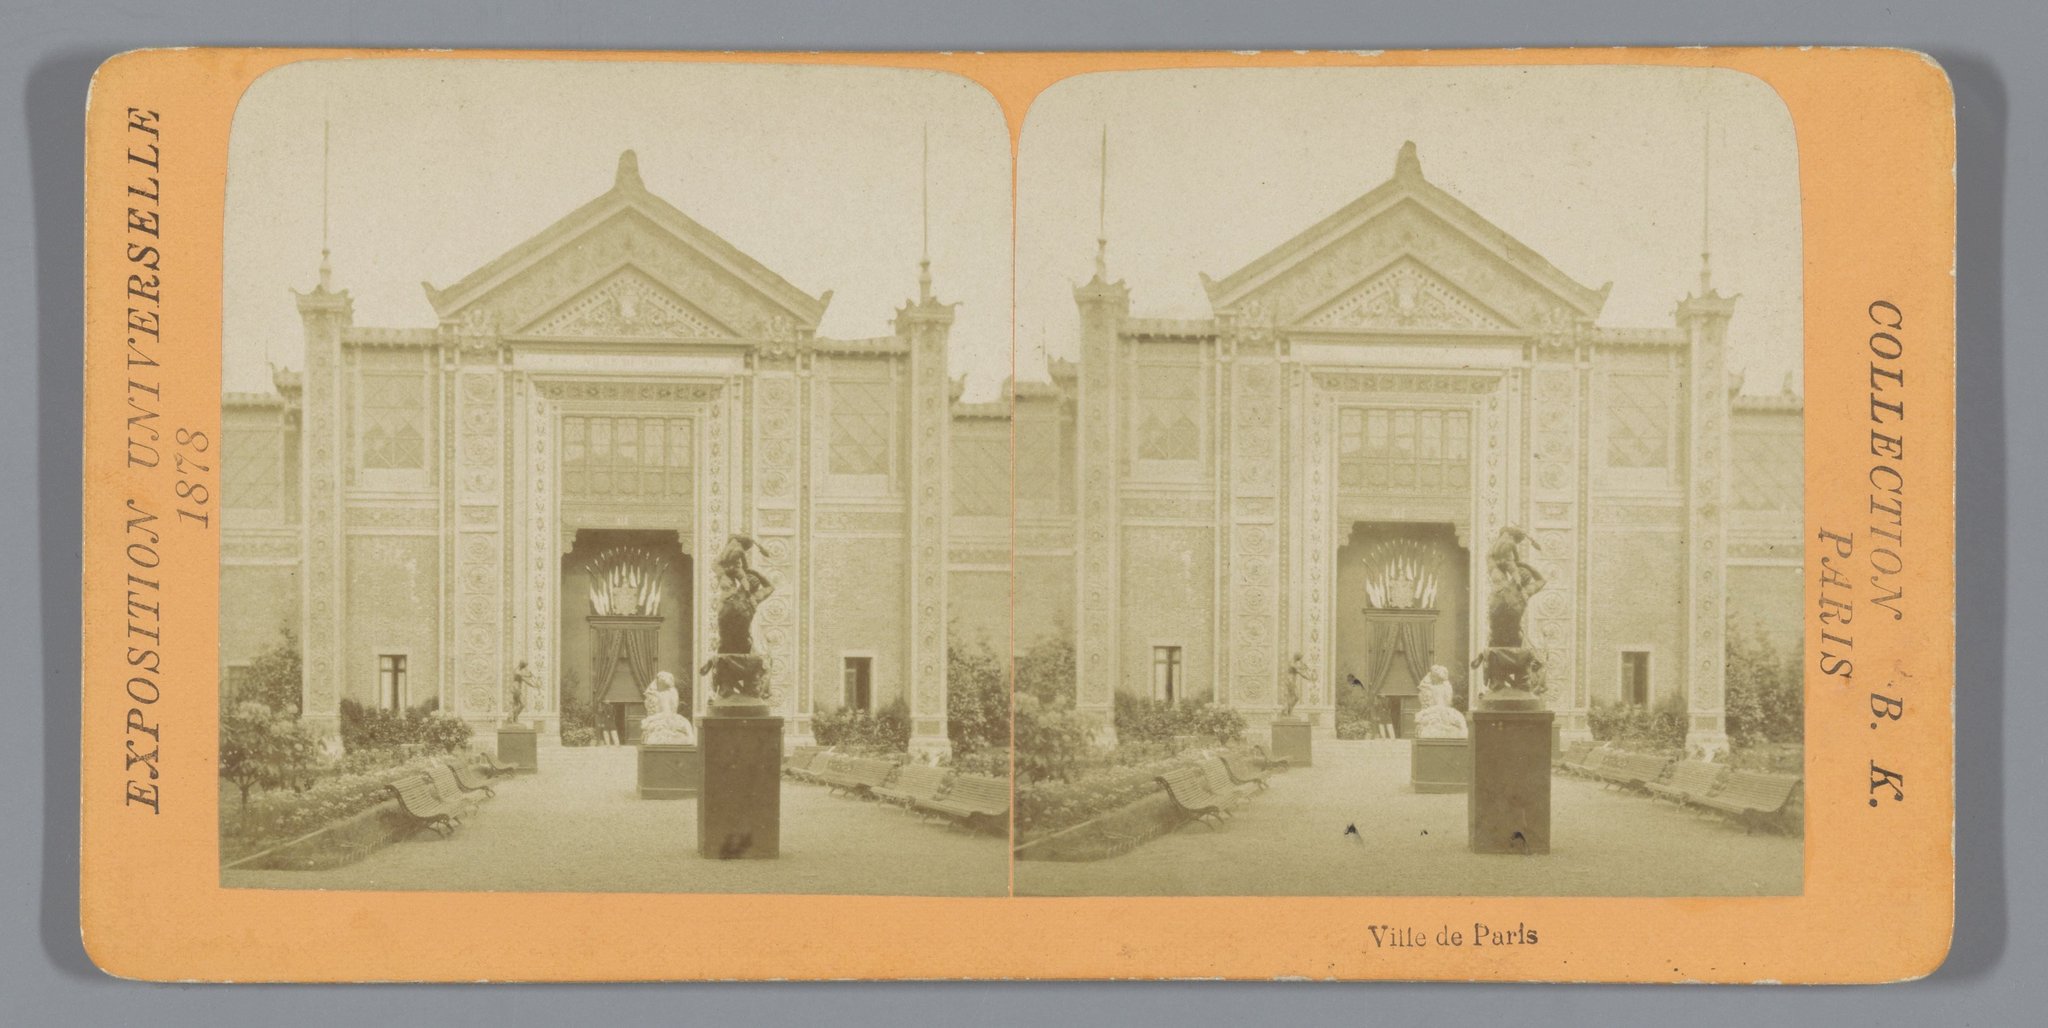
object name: stereograph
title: Exposition Universelle 1878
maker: adolphe block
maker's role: publisher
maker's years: 1829-1918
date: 1878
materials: cardboard, paper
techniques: albumen print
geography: paris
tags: world fair, world exhibition, paris